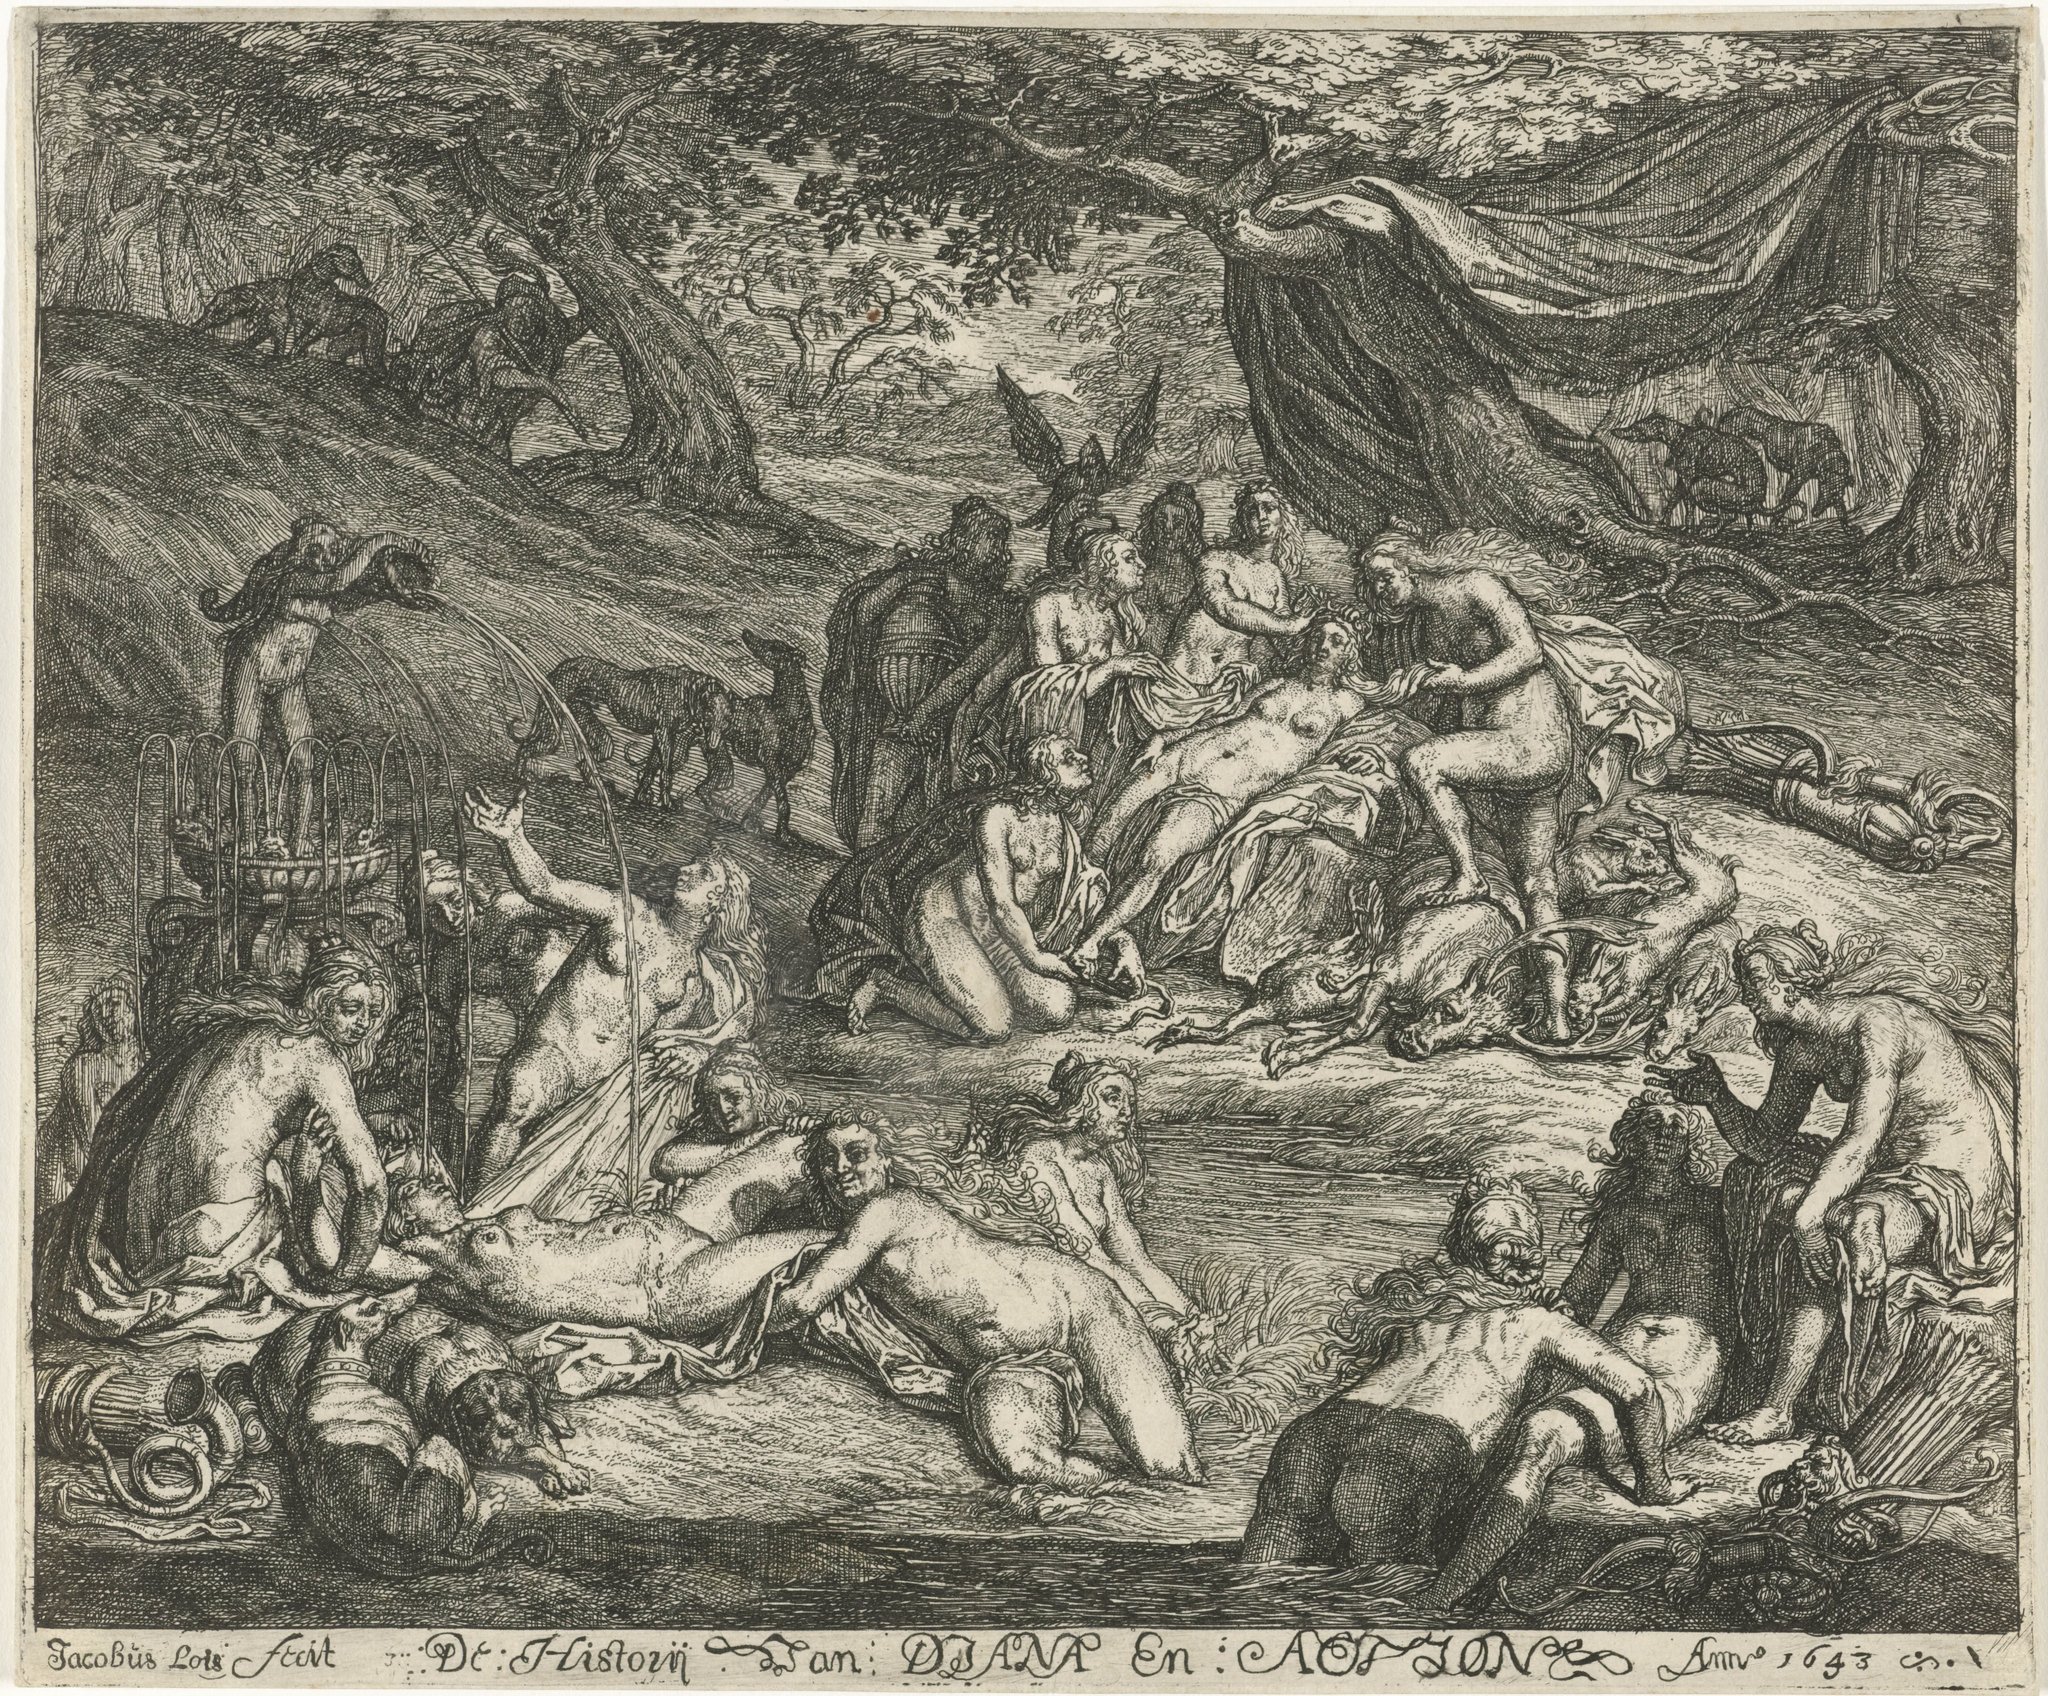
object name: print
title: De Historij Van Diana En Acteon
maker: jacob lois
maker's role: draughtsman, print maker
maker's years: -1676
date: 1643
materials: paper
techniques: etching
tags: diana with her nymphs discovers the pregnancy of callisto, pregnancy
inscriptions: collector's mark: Lugt 2228, collector's mark: Lugt 514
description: Op een open plek in het bos wordt de liggende Diana omringd en verwend door haar gevolg. Ze heeft ontdekt dat Callisto, een van haar nimfen, zwanger is. Op de voorgrond wordt de zwangere Callisto door nimfen onder een fontein tegen de grond geduwd.